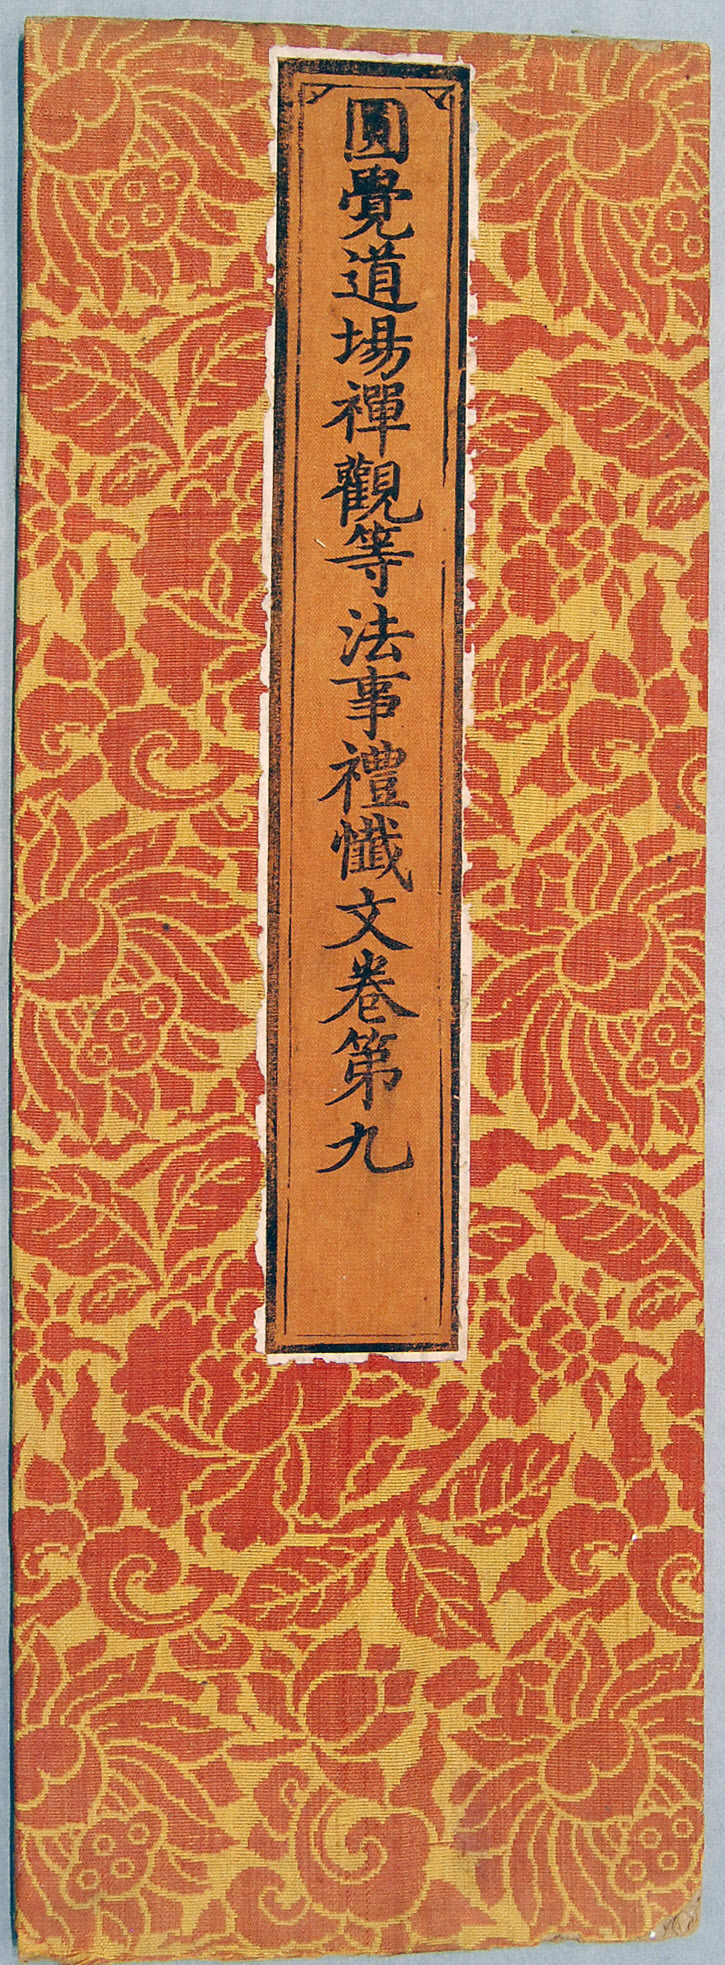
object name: sutra cover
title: Sutra Cover with Flowers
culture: chinese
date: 1501-1600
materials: silk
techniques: patterning, weave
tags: lotuses,peonies